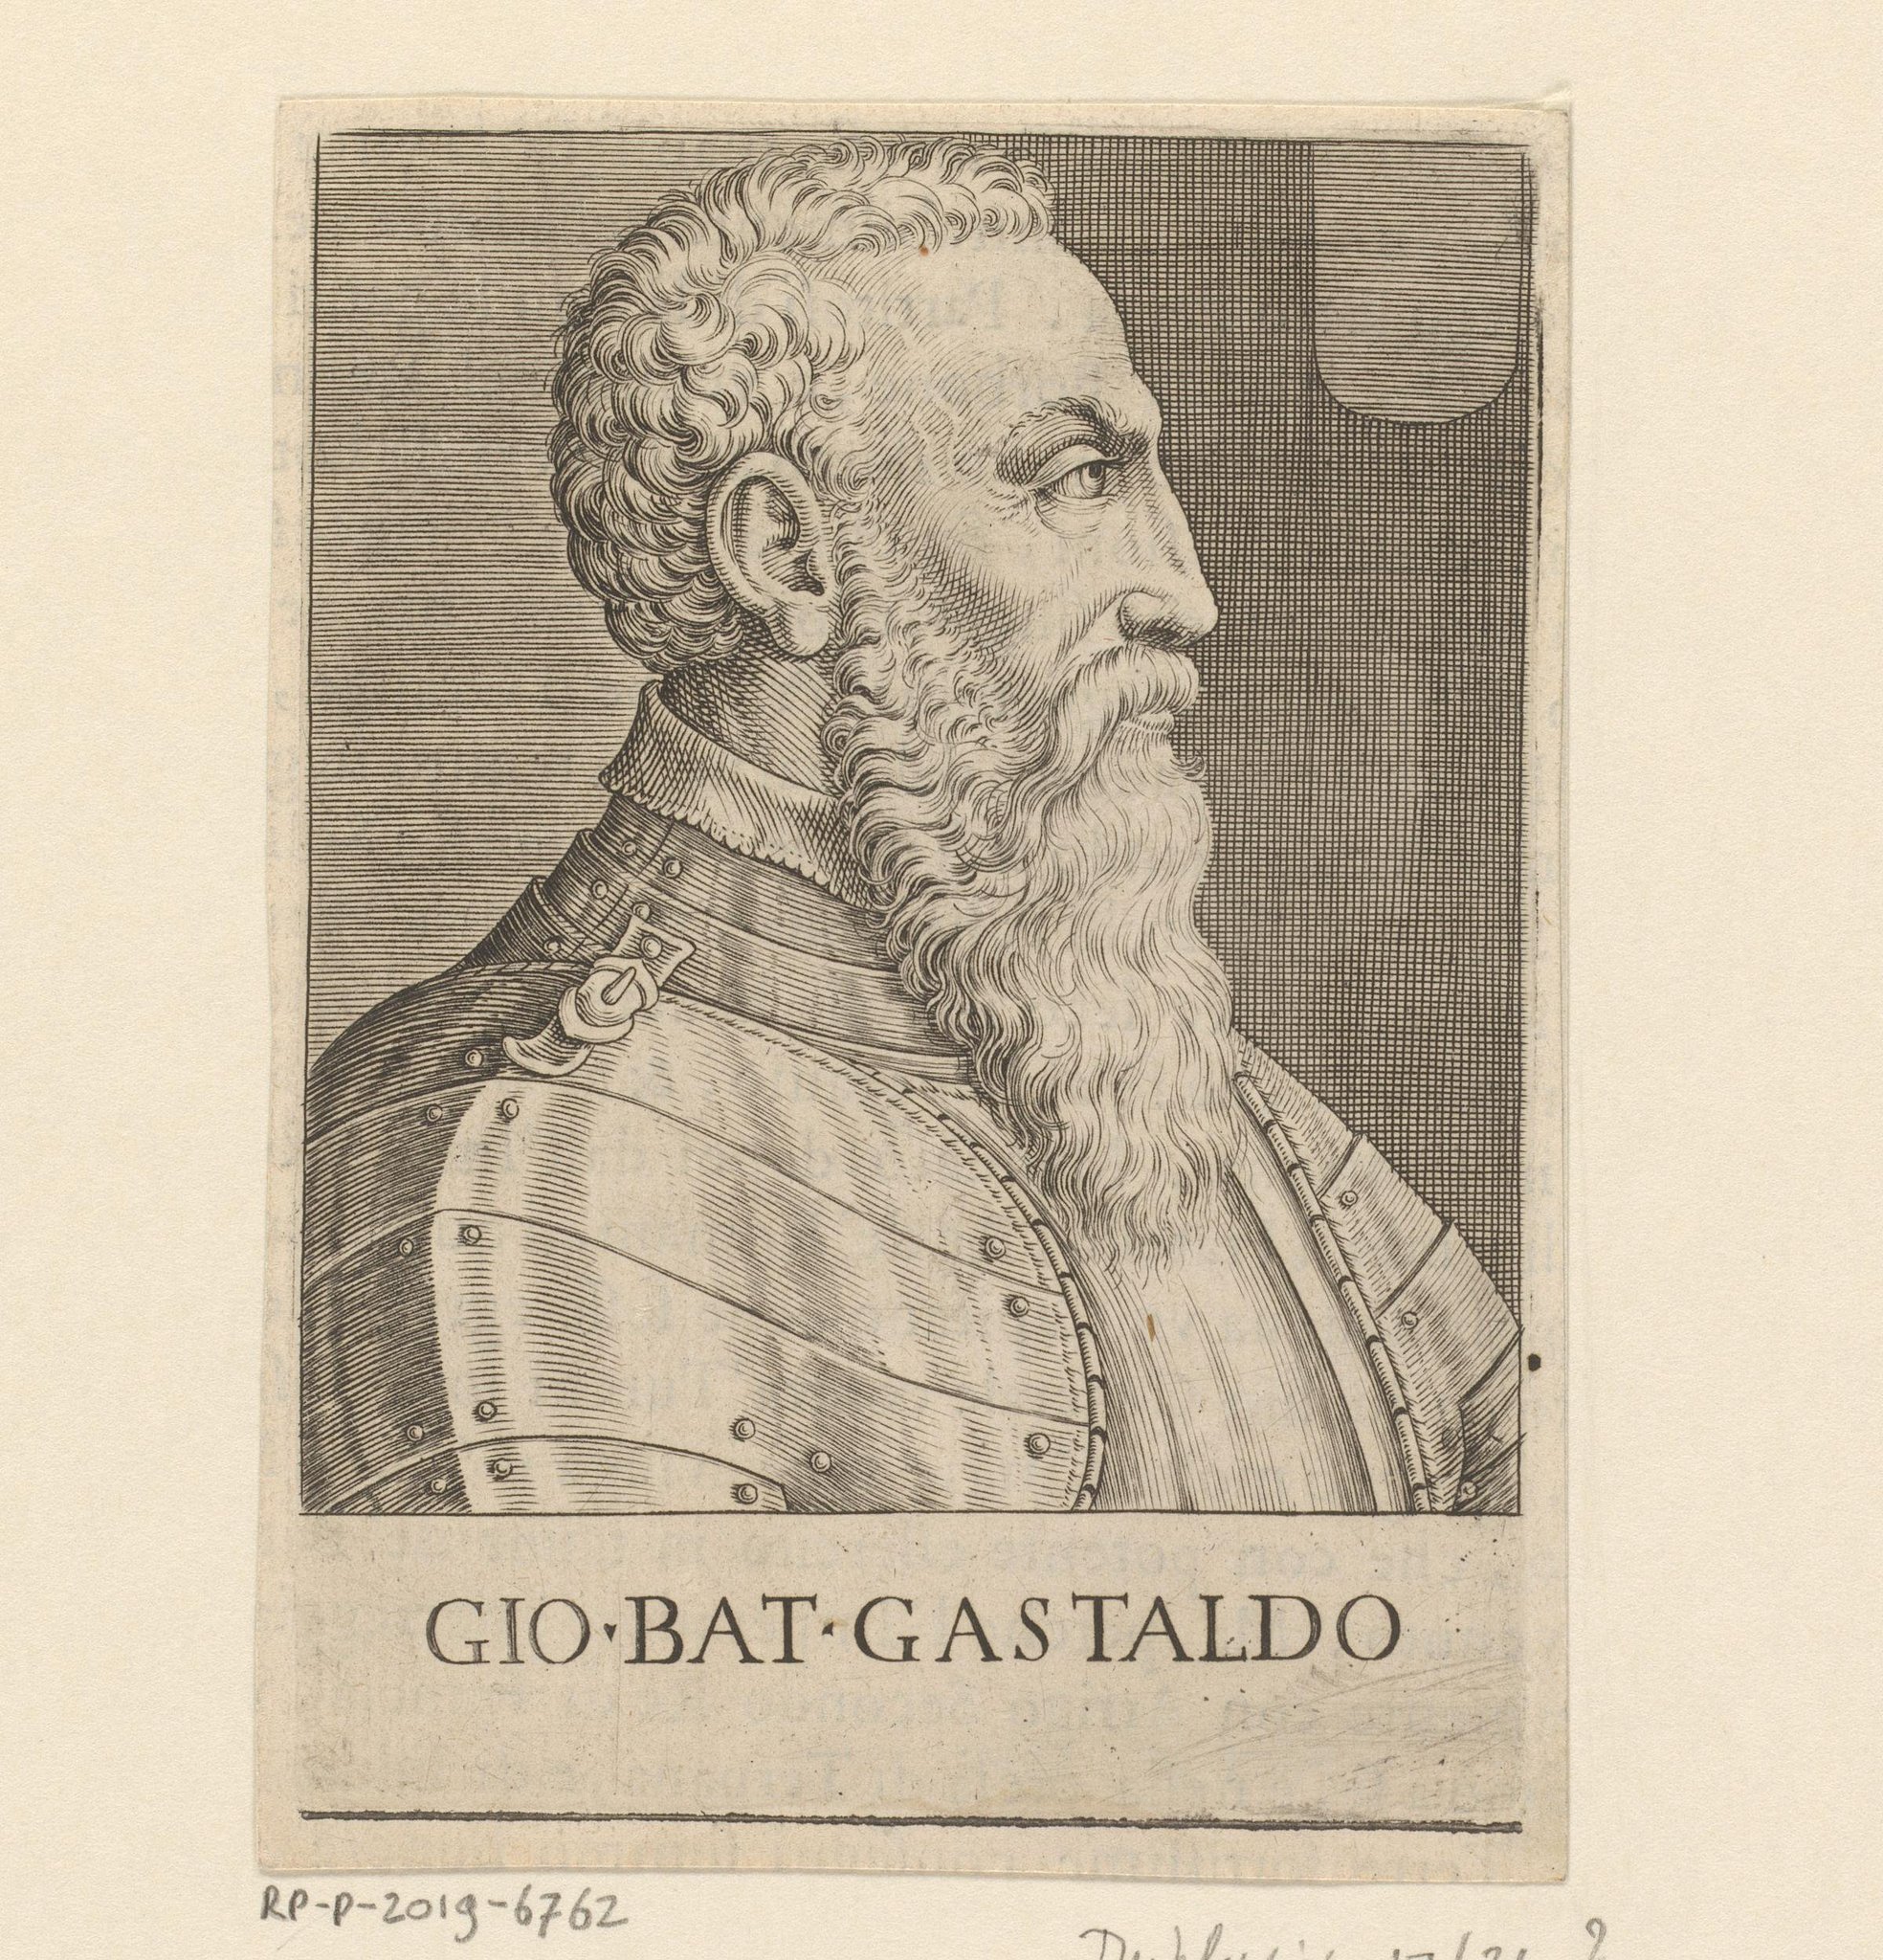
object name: print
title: Portret van legeraanvoerder Giovanni Battista Gastaldo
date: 1646-1647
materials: paper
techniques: engraving, letterpress printing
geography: rome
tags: commander-in-chief, general, marshal, historical persons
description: Prent uit: Ritratti et elogii di capitani Illustri. Che ne'secoli moderni hanno gloriosamente guerreggiato. Rome: Filippo de'Rossi en Vitale Mascardi, 1646, p. 343. Prent ook gebruikt in dezelfde editie van 1647. Eerdere staten van prent in ieder geval gebruikt in: Ritratti et elogii di capitani Illustri. Rome: Pompilio Totti en Andrea Fei, 1635. En in: Ritratti di cento capitani illustri con li lor Fatti in guerra (…), Rome: Domenico Gigliotti, 1596.